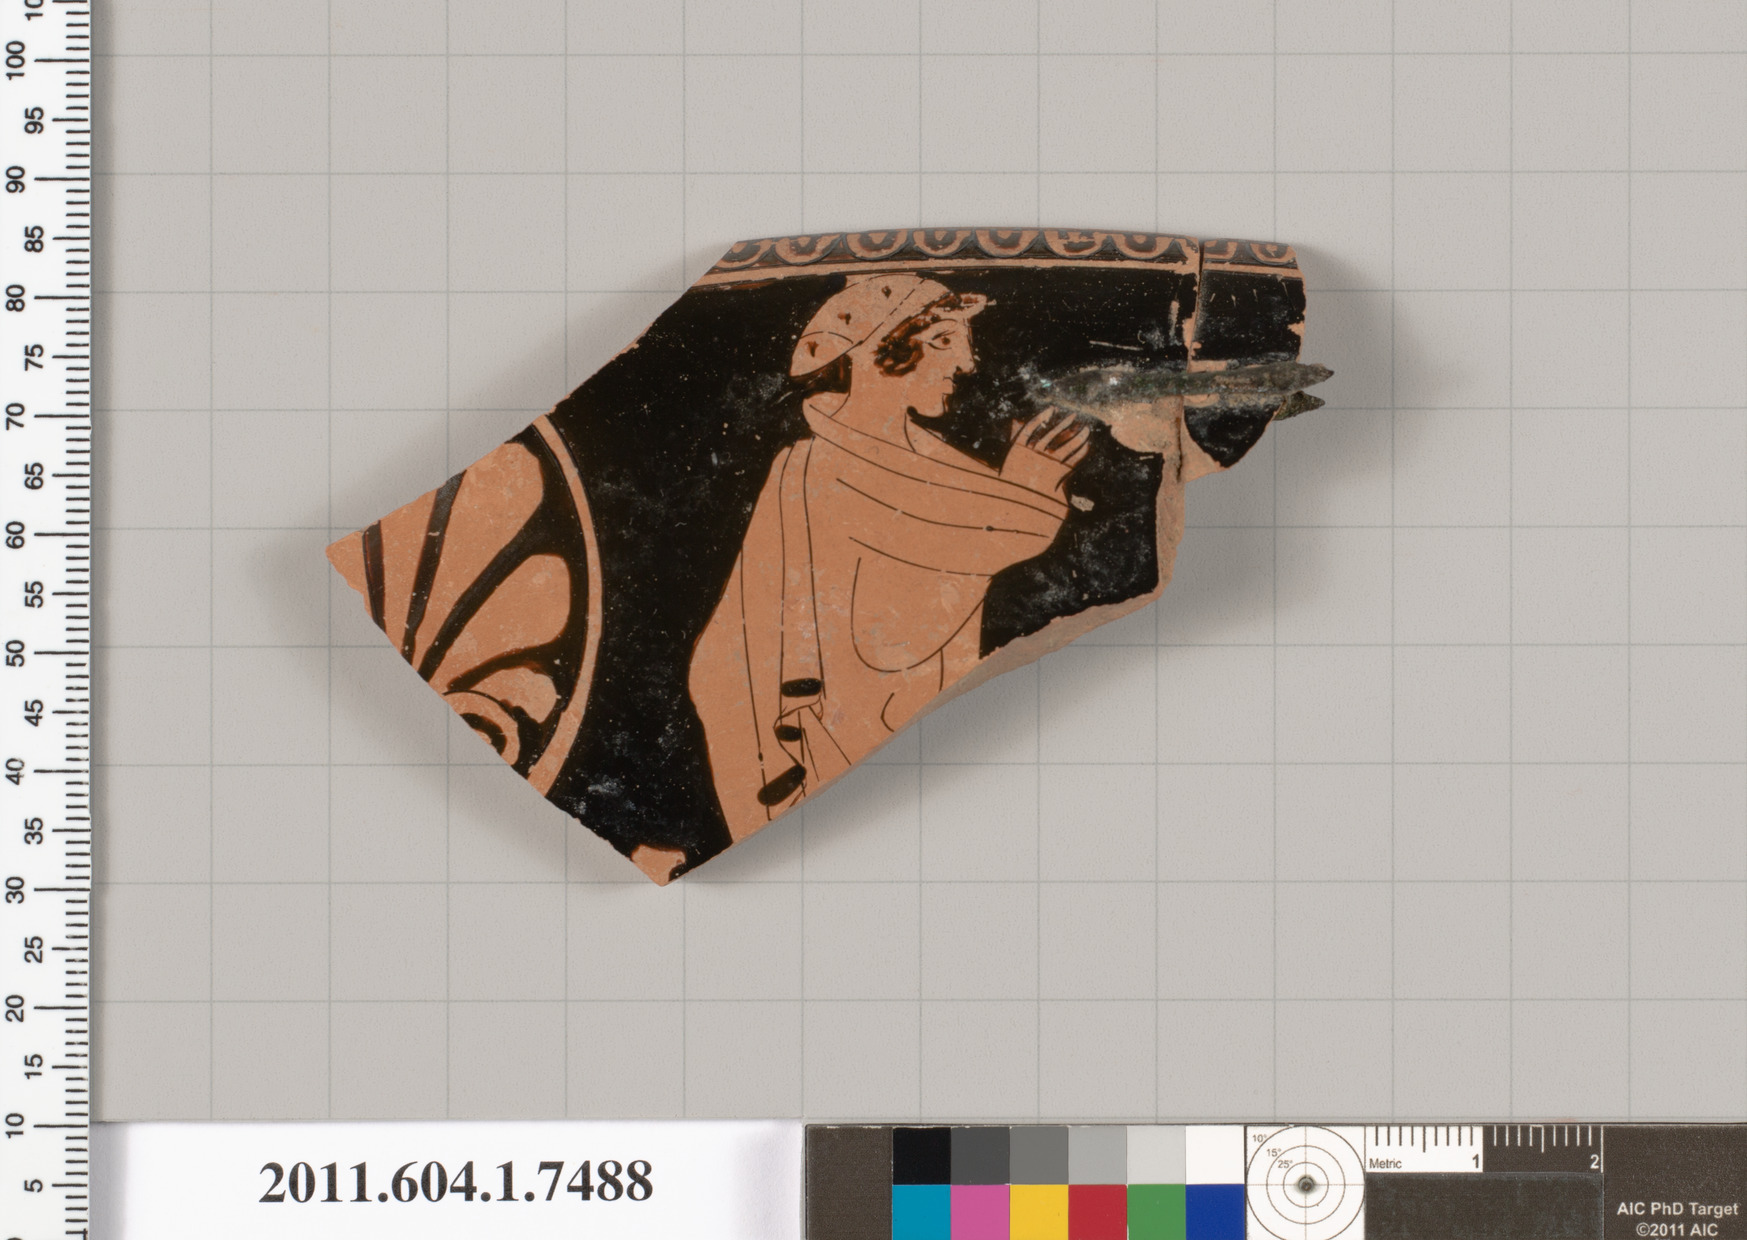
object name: kylix fragment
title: Terracotta rim fragment of a kylix (drinking cup)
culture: greek, attic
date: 467-435 BCE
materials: terracotta